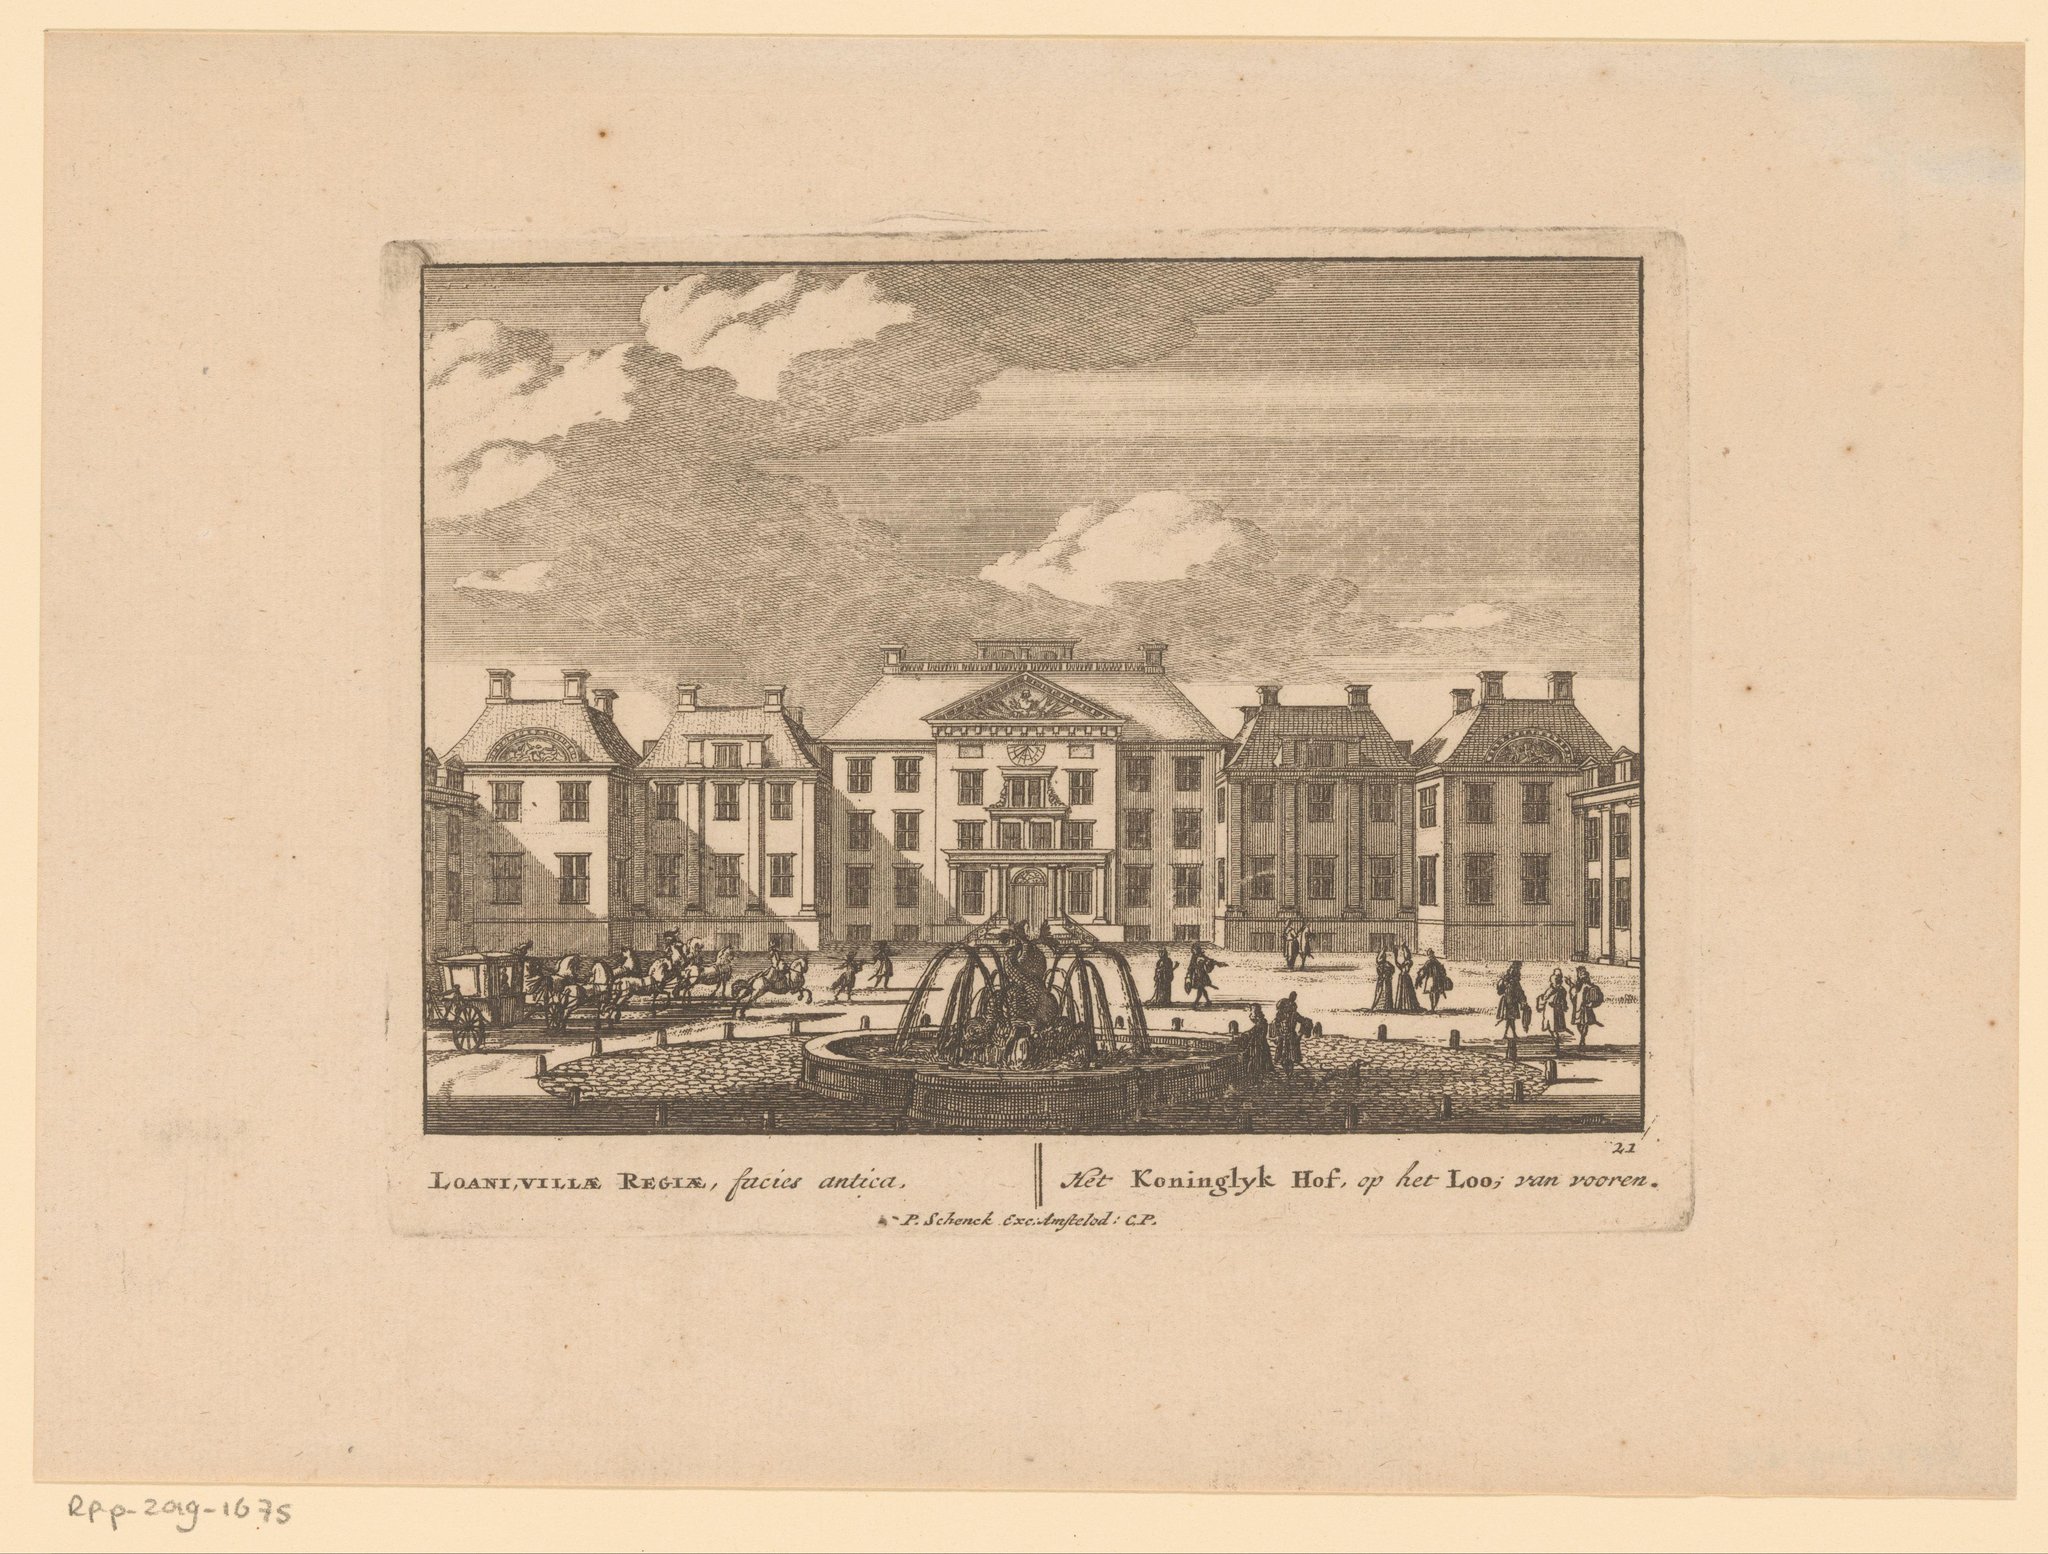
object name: print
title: Gezicht op Paleis het Loo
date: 1700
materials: paper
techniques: etching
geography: amsterdam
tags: palace, ornamental fountain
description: Andere staat ook gebruikt in: Call, Jan van. Admirandorum Quadruplex Spectaculum. Amsterdam: Pieter Schenk (I), [1700].* * De titelprent, opdracht en het portret van Frederik van Saksen zijn gegraveerd door Pieter Schenk (I). De overige prenten uit deze serie zijn, zoals aangegeven op de titelprent, van de hand van Jan van Call (I).